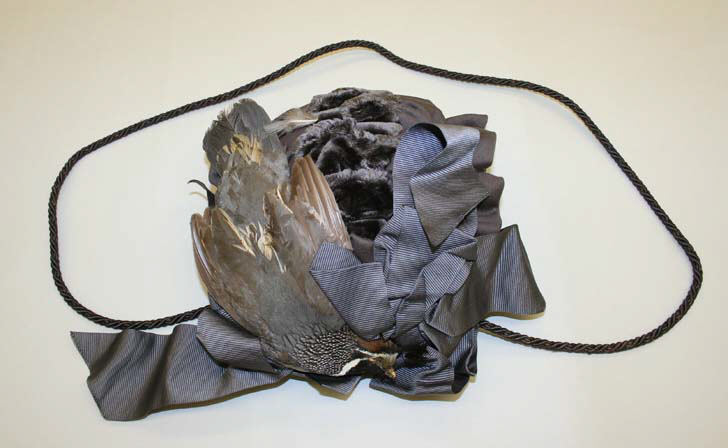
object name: muff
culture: american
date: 1886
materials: silk, wool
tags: birds